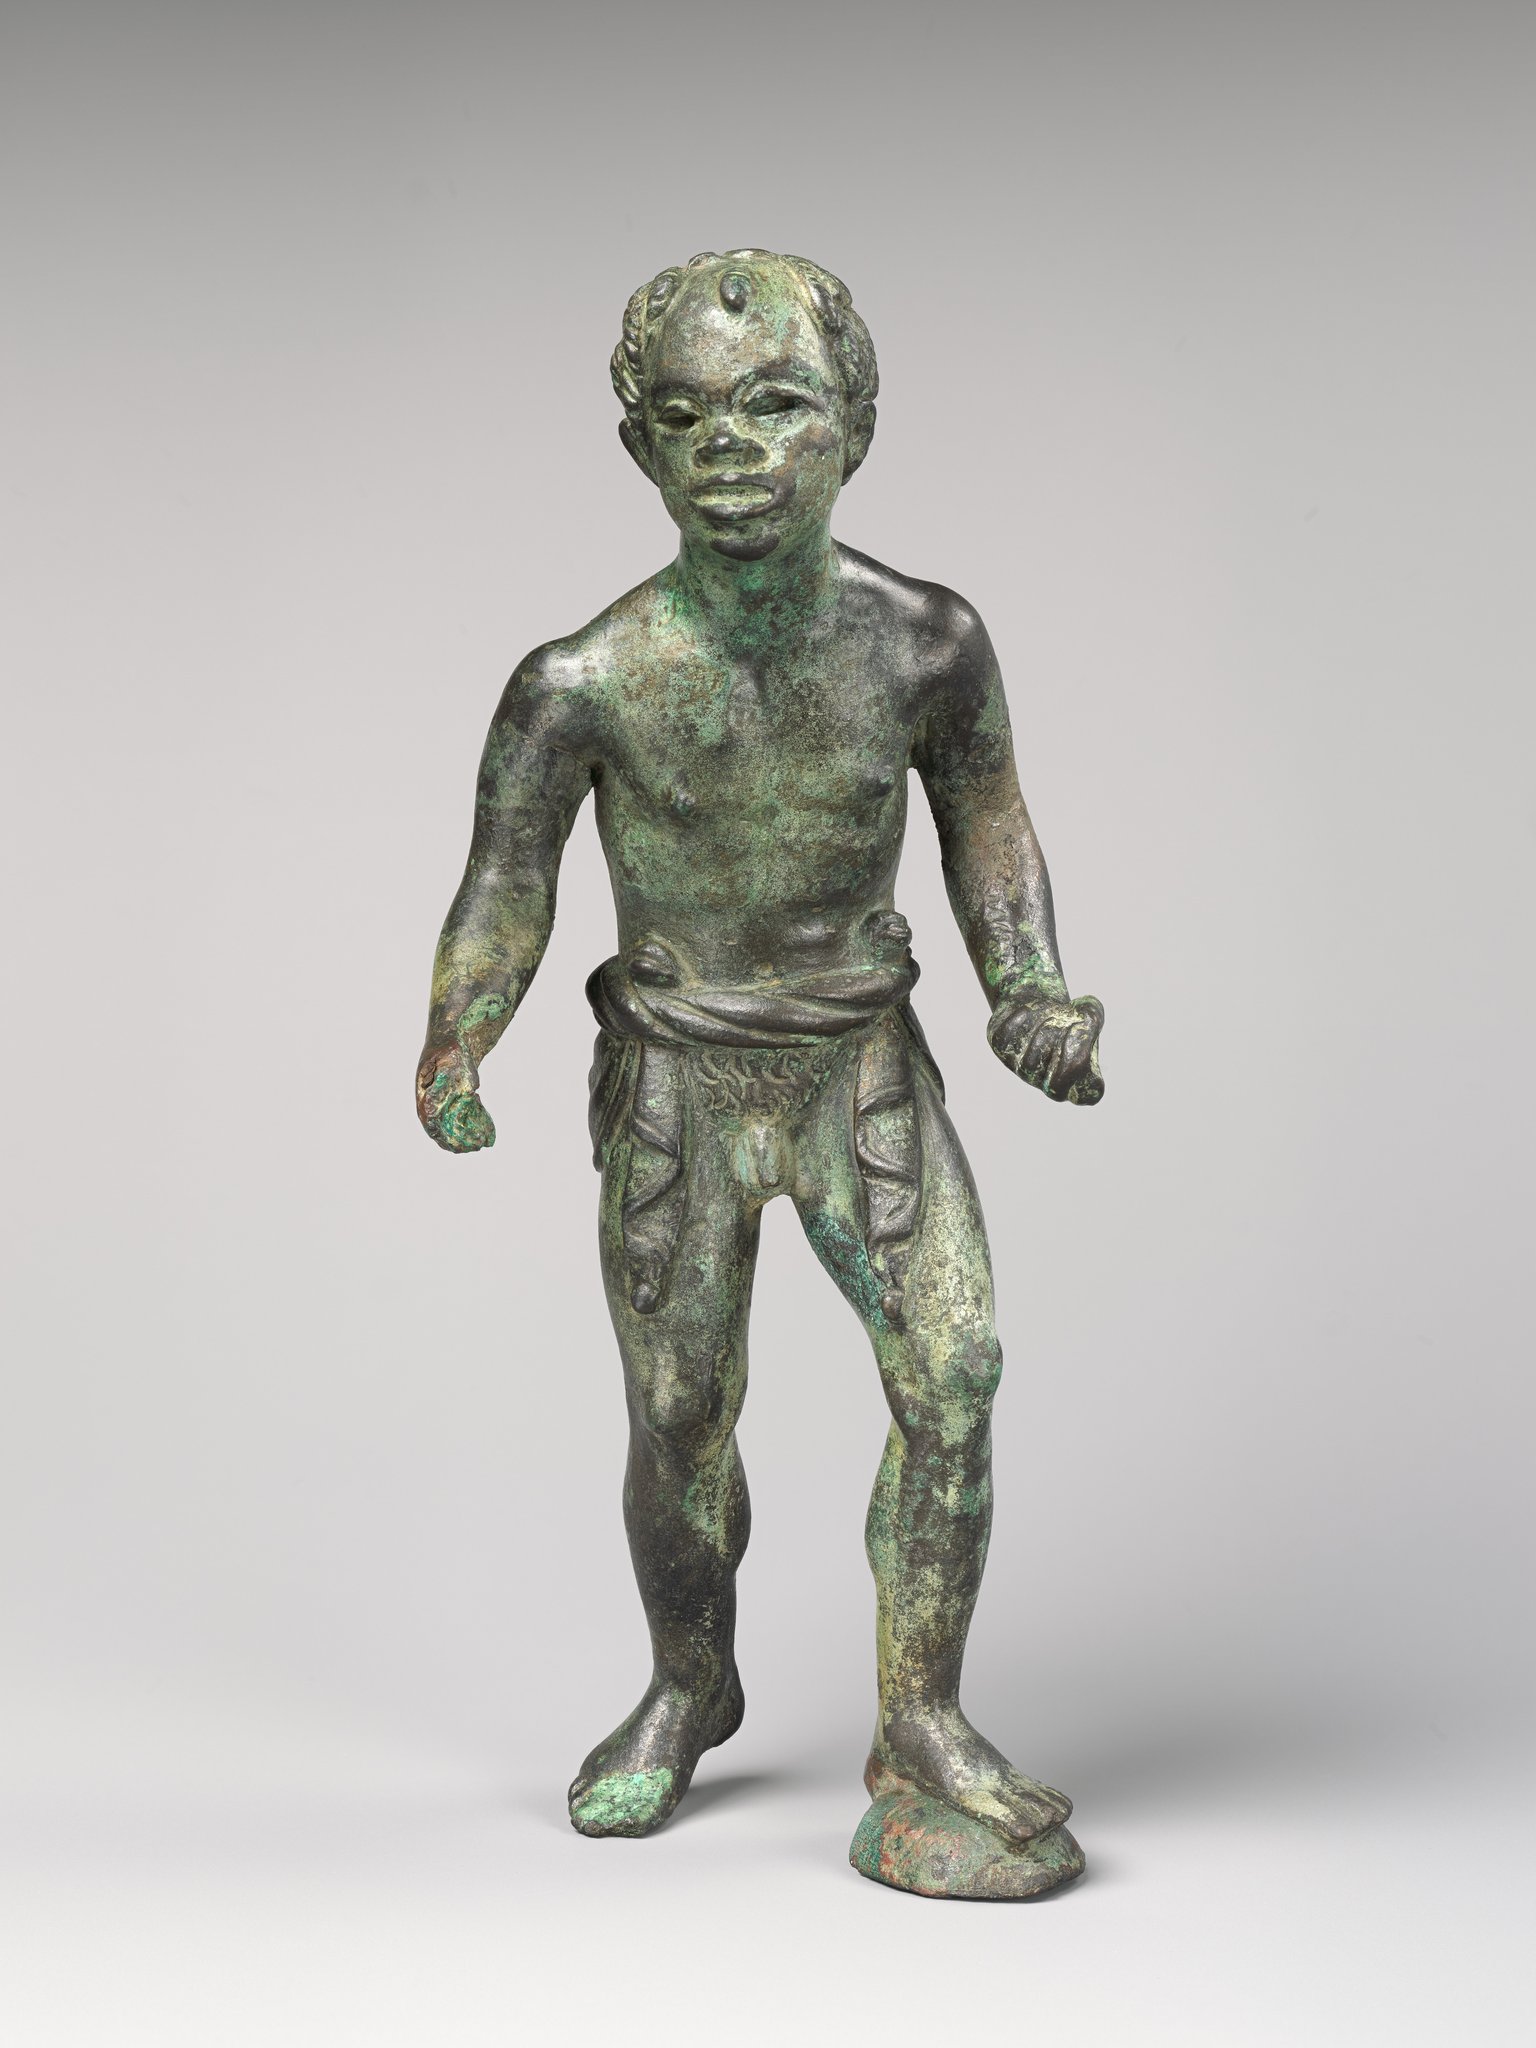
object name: statuette of a black youth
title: Bronze statuette of a Black African youth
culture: greek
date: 300-101 BCE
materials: bronze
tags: male nudes